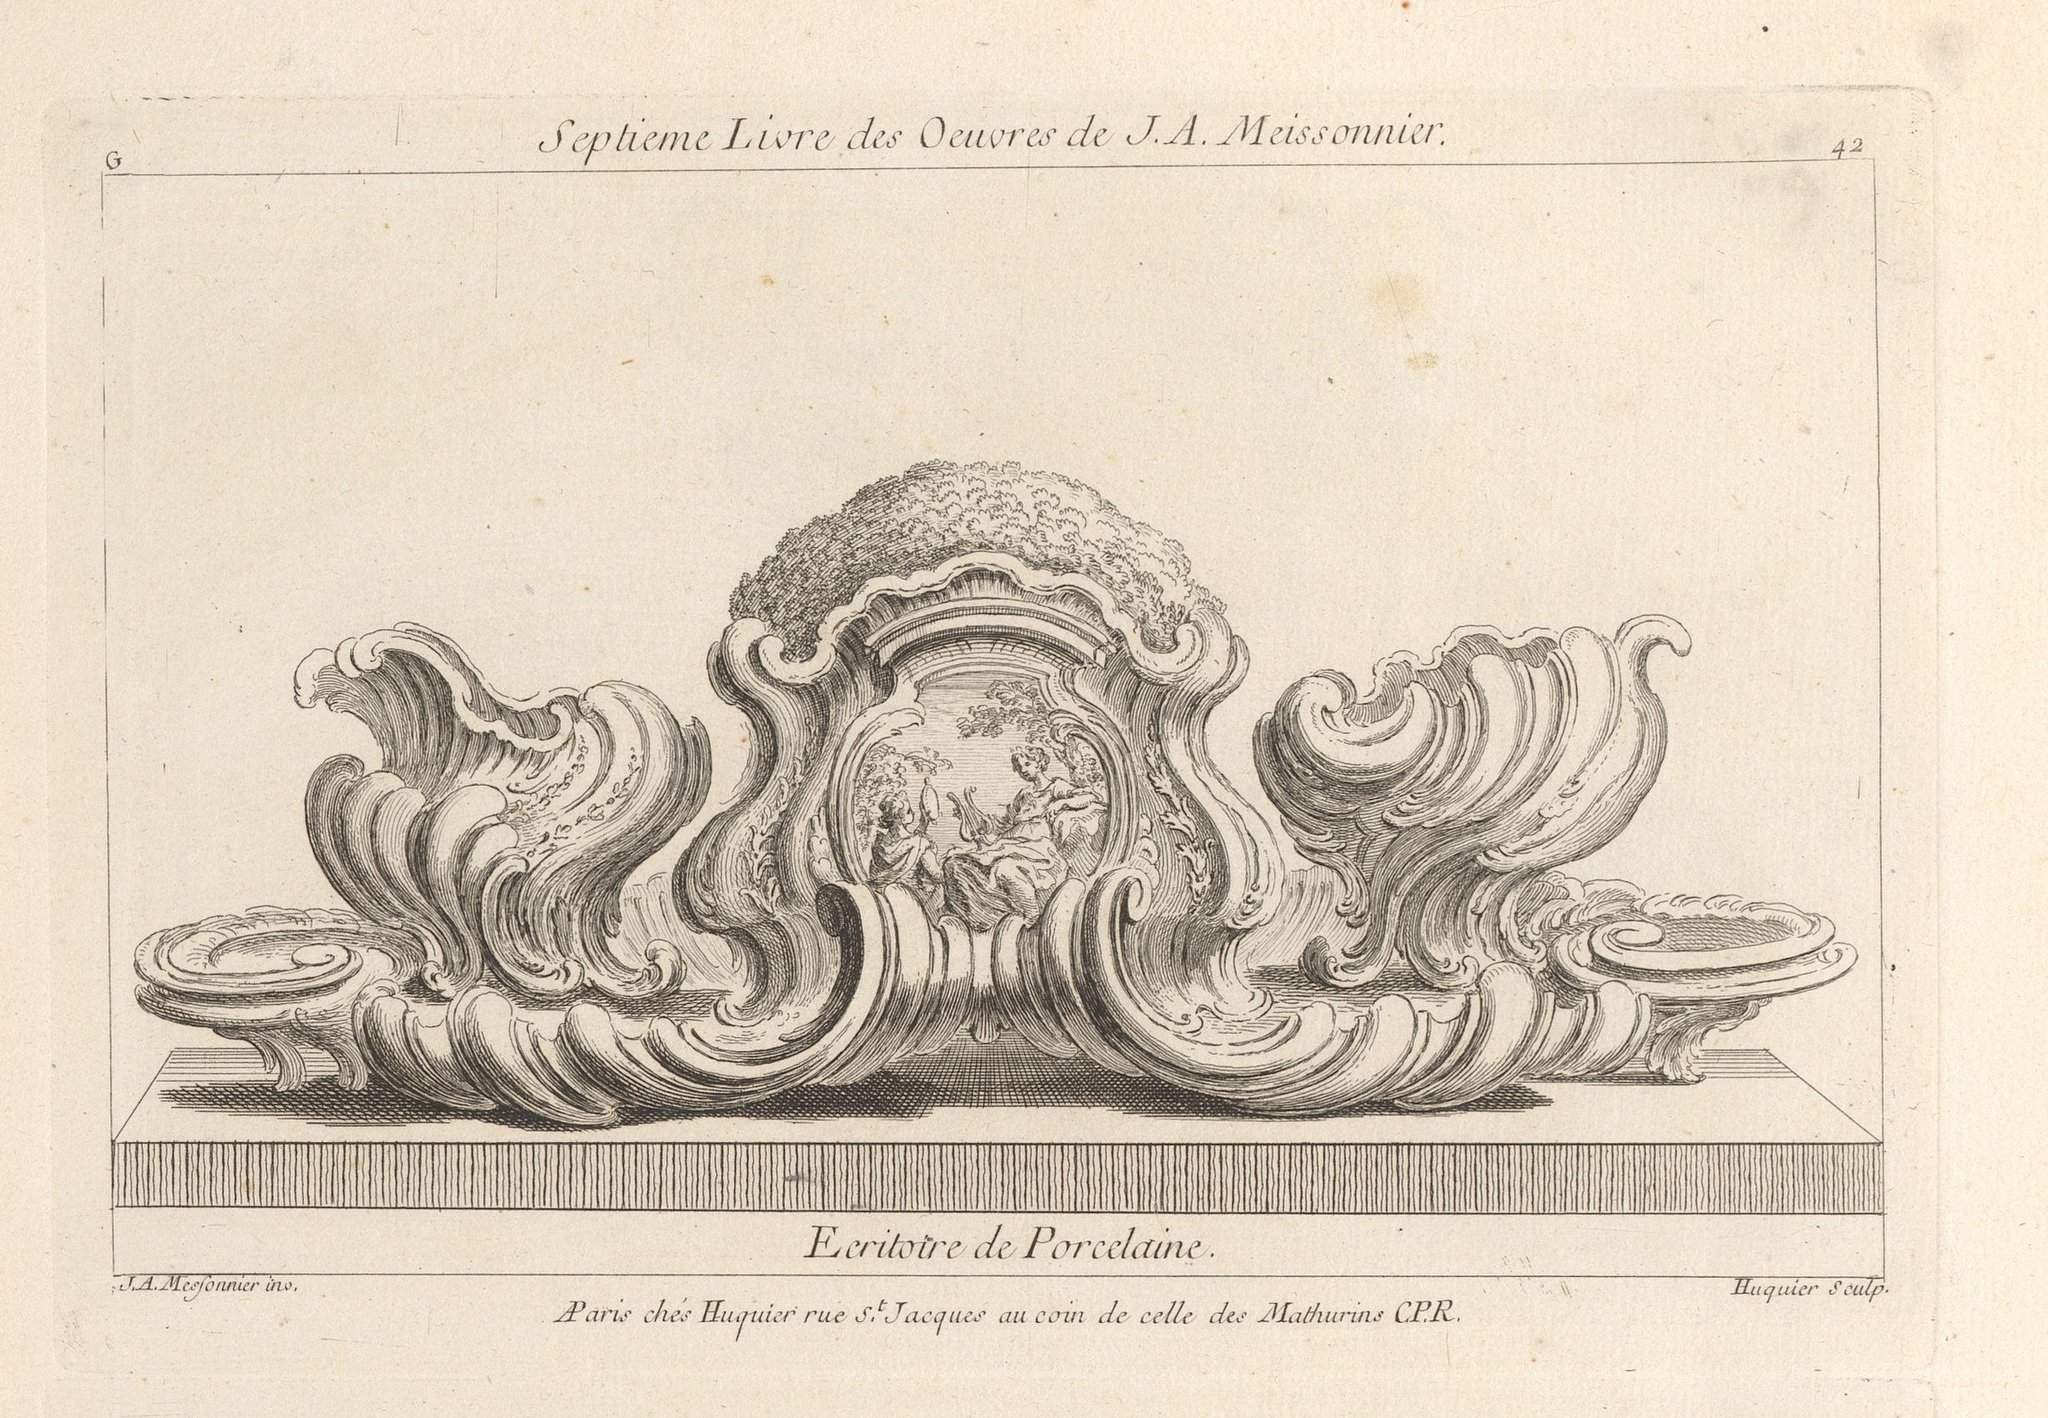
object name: ornament print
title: Oeuvre de Juste Aurele Meissonnier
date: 1738-1749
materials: paper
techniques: etching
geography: paris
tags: ink-well, work of applied art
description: RP-P-1998-280 vertoont hetzelfde inkstel, dan van boven gezien. Deze prent maakt deel uit van de serie 'Septième livre des oeuvres de mr. Messonnier', een van de delen van de monumentale serie 'Oeuvre de Juste Aurele Meissonnier'.